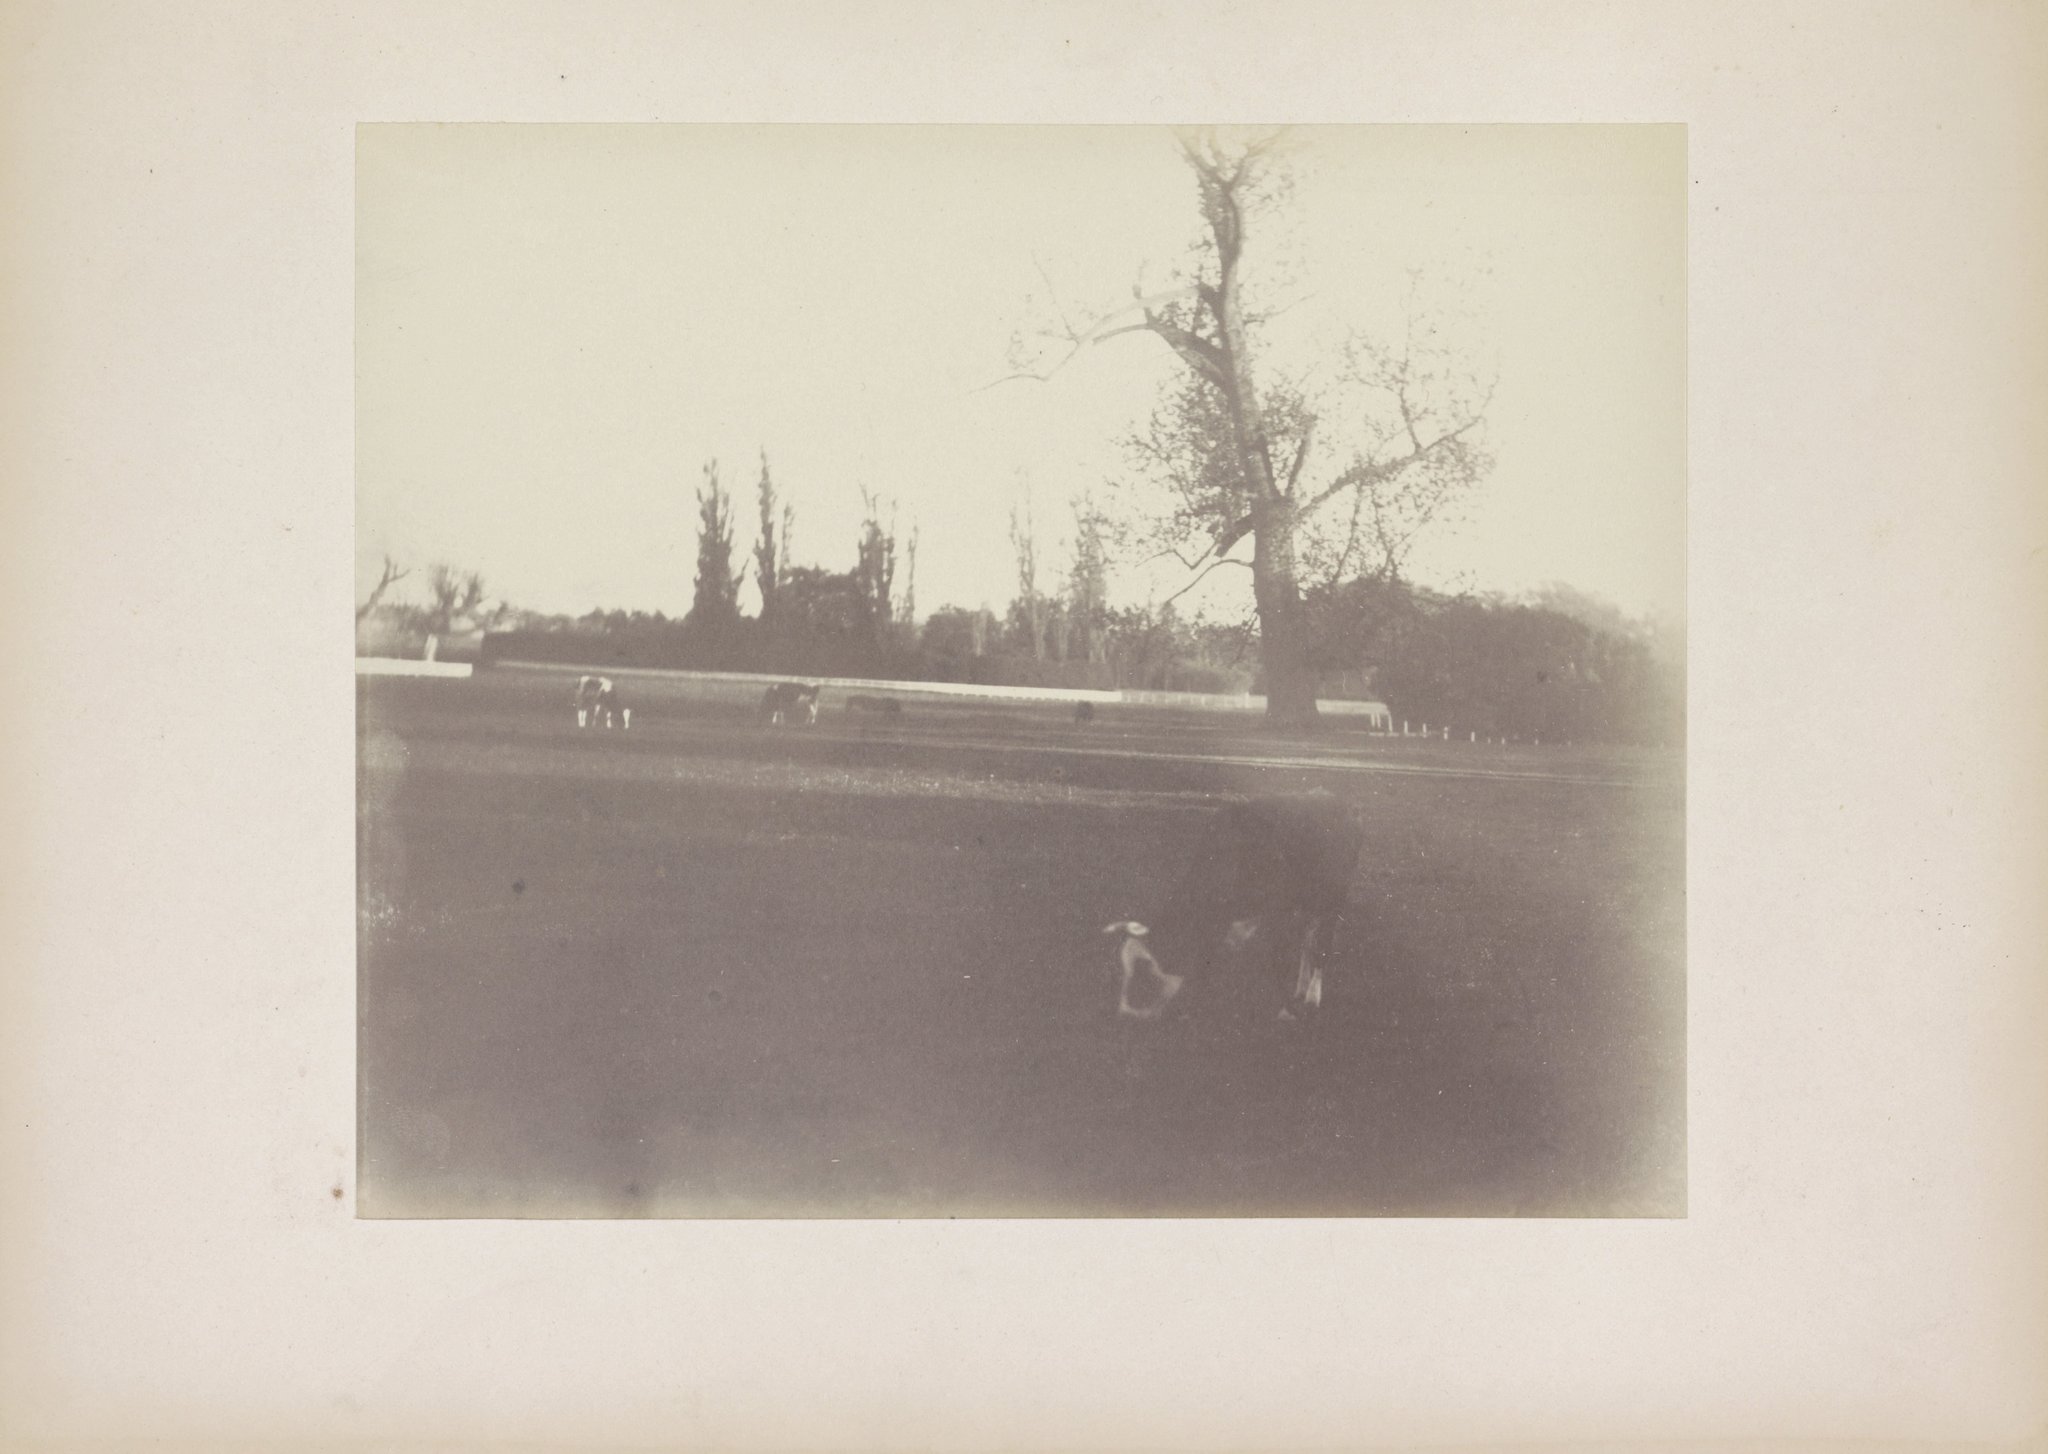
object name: photograph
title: Landschap met koeien in een weiland in Nederland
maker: Anonymous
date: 1885-1900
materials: paper, photographic support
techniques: albumen print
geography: netherlands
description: Landschap met koeien in een weiland, Nederland